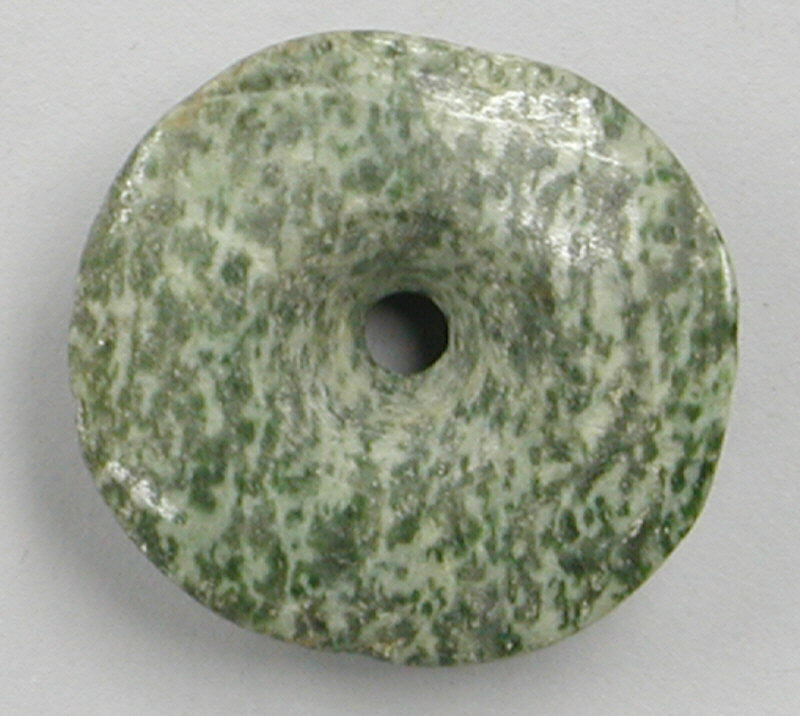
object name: earflare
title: Stone Earflare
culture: mexican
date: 1501-1600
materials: stone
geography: mexico